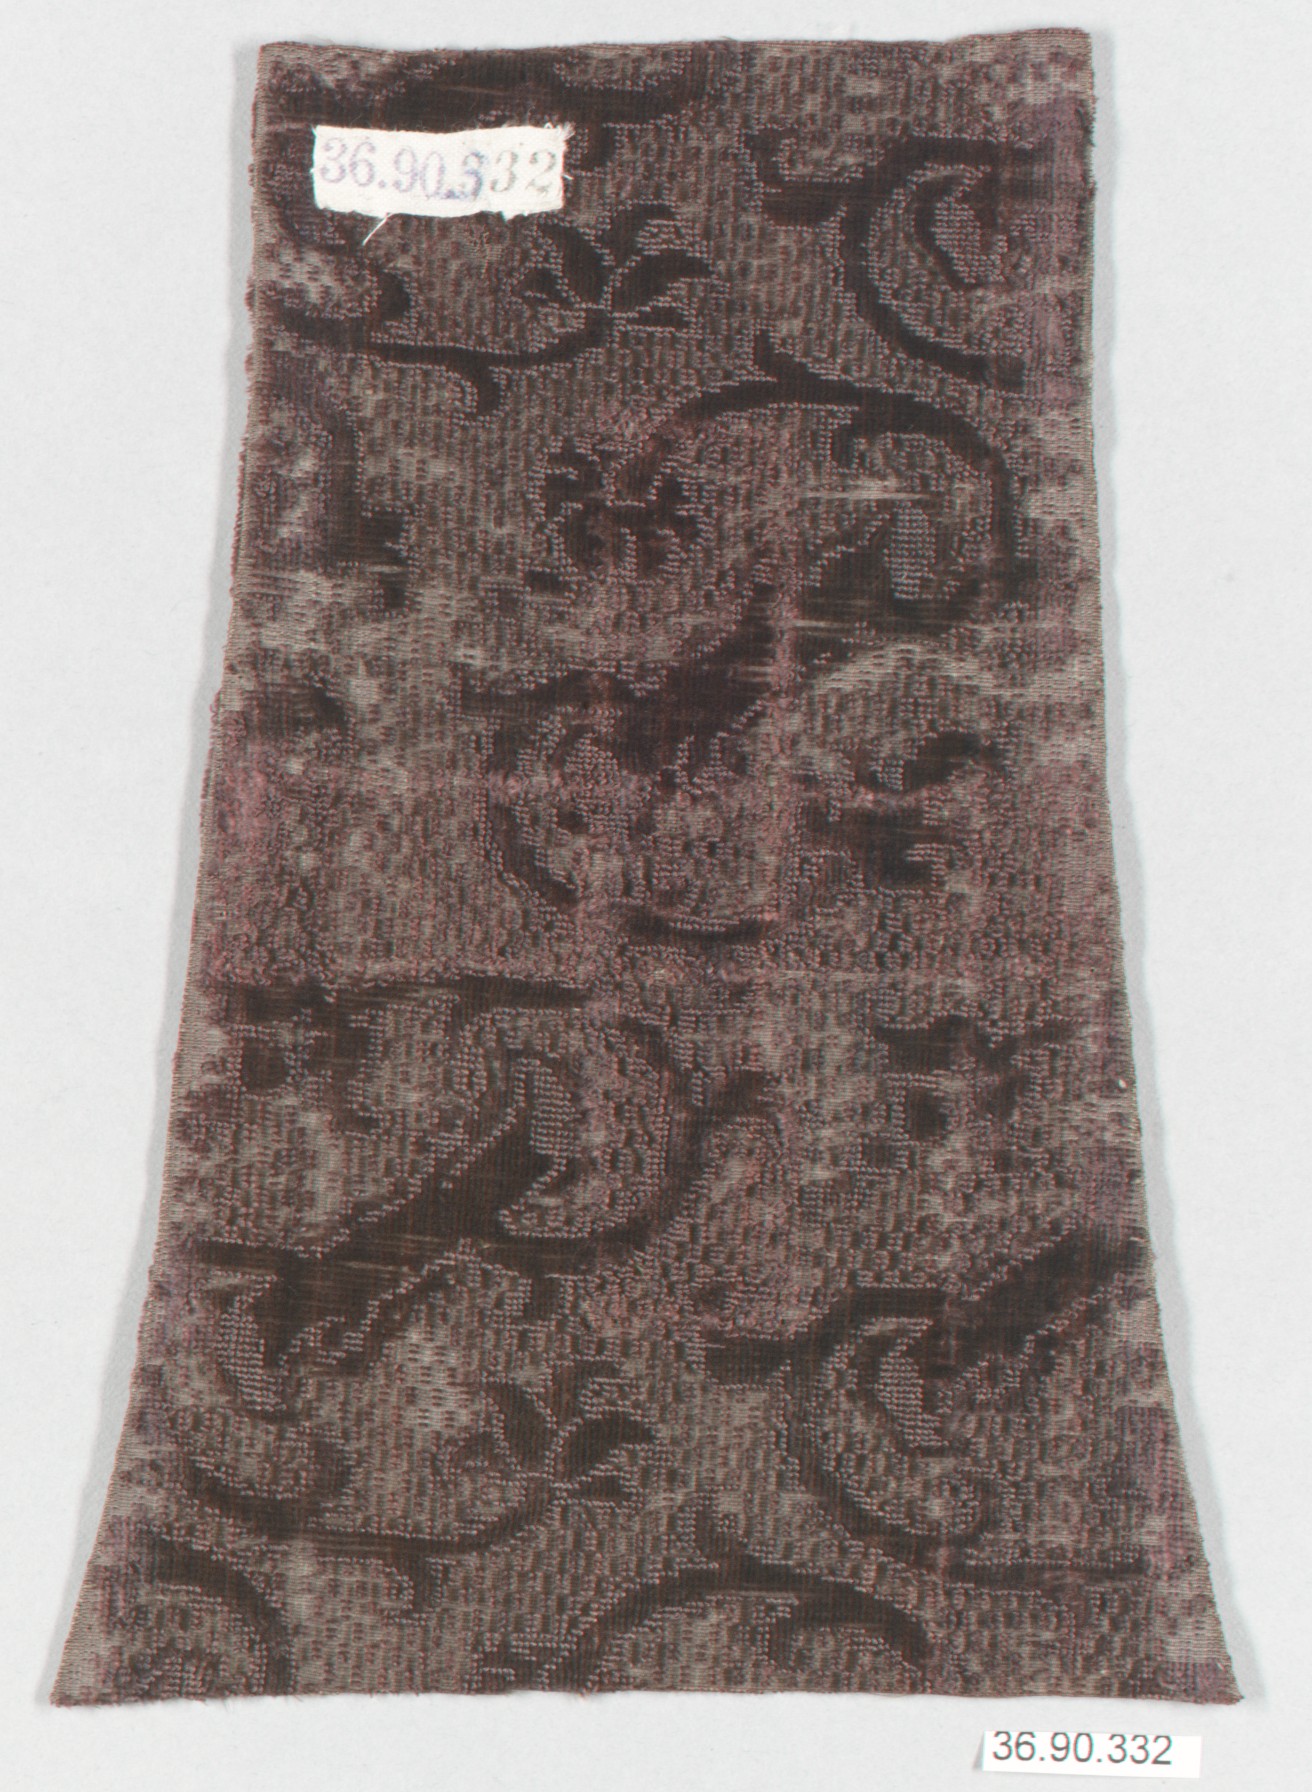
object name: piece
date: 1501-1700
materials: silk